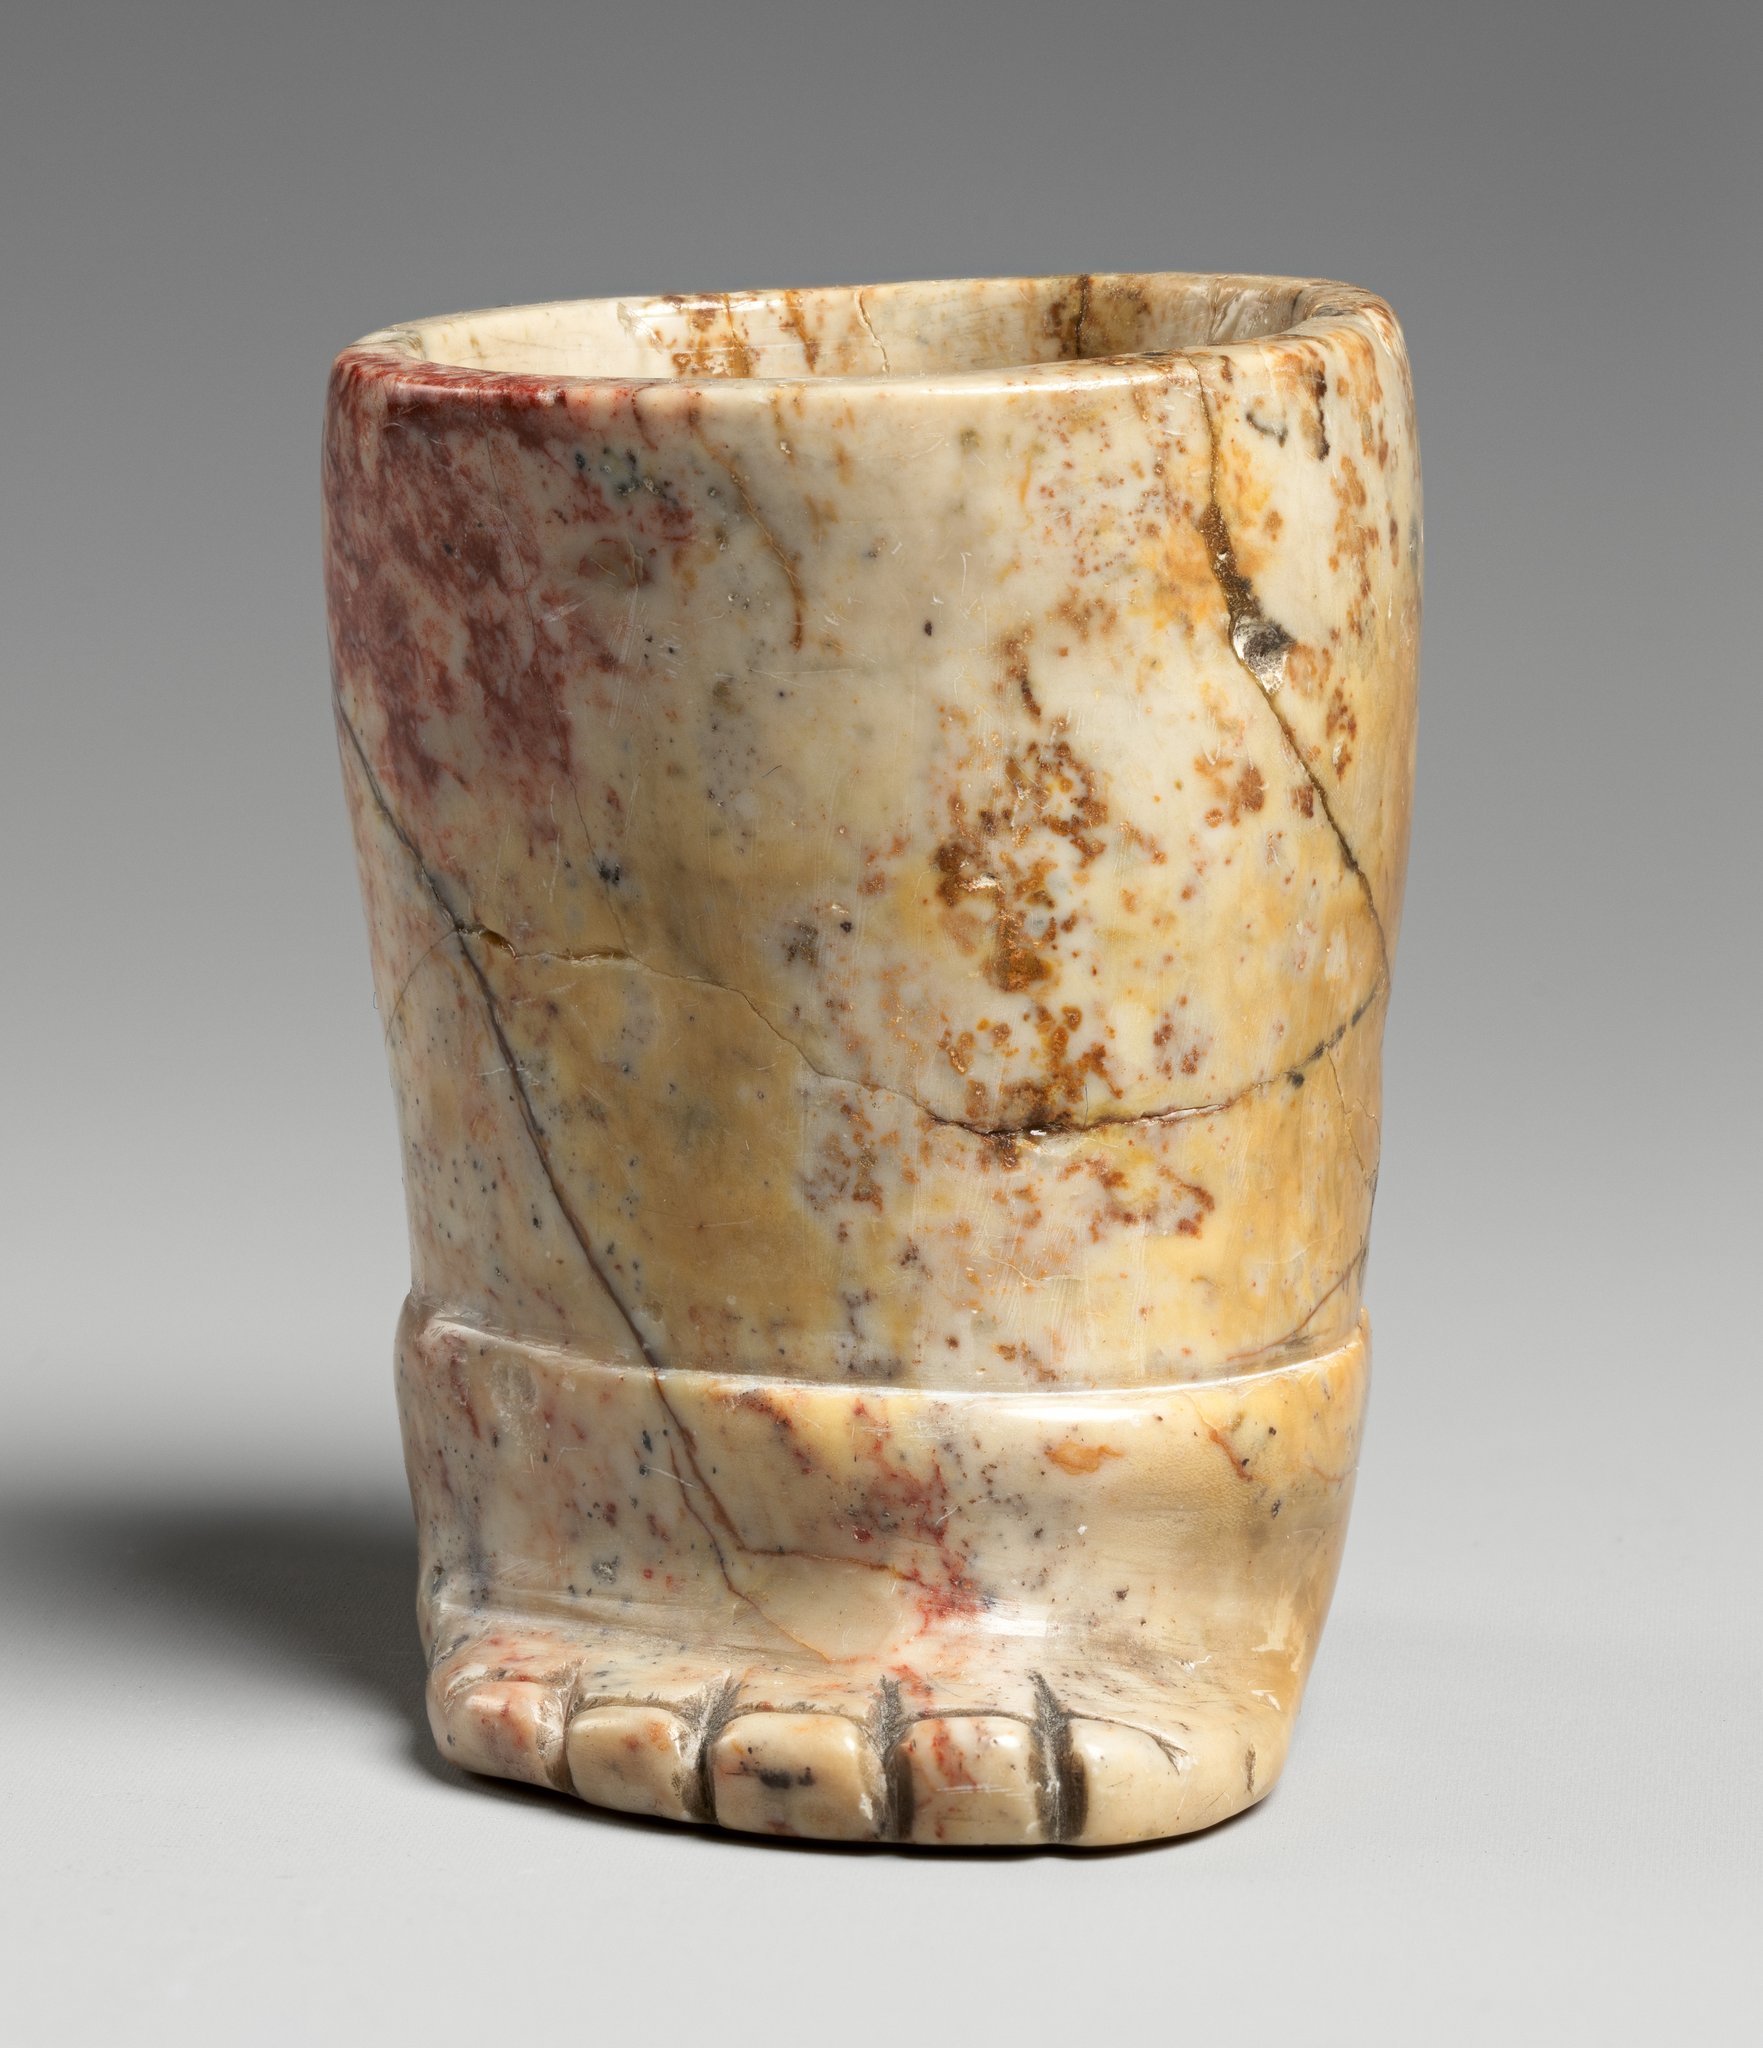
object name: lime container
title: Beaker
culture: chavín or cupisnique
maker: cupisnique artist(s)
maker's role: artist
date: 1200-500 BCE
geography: peru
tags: feet